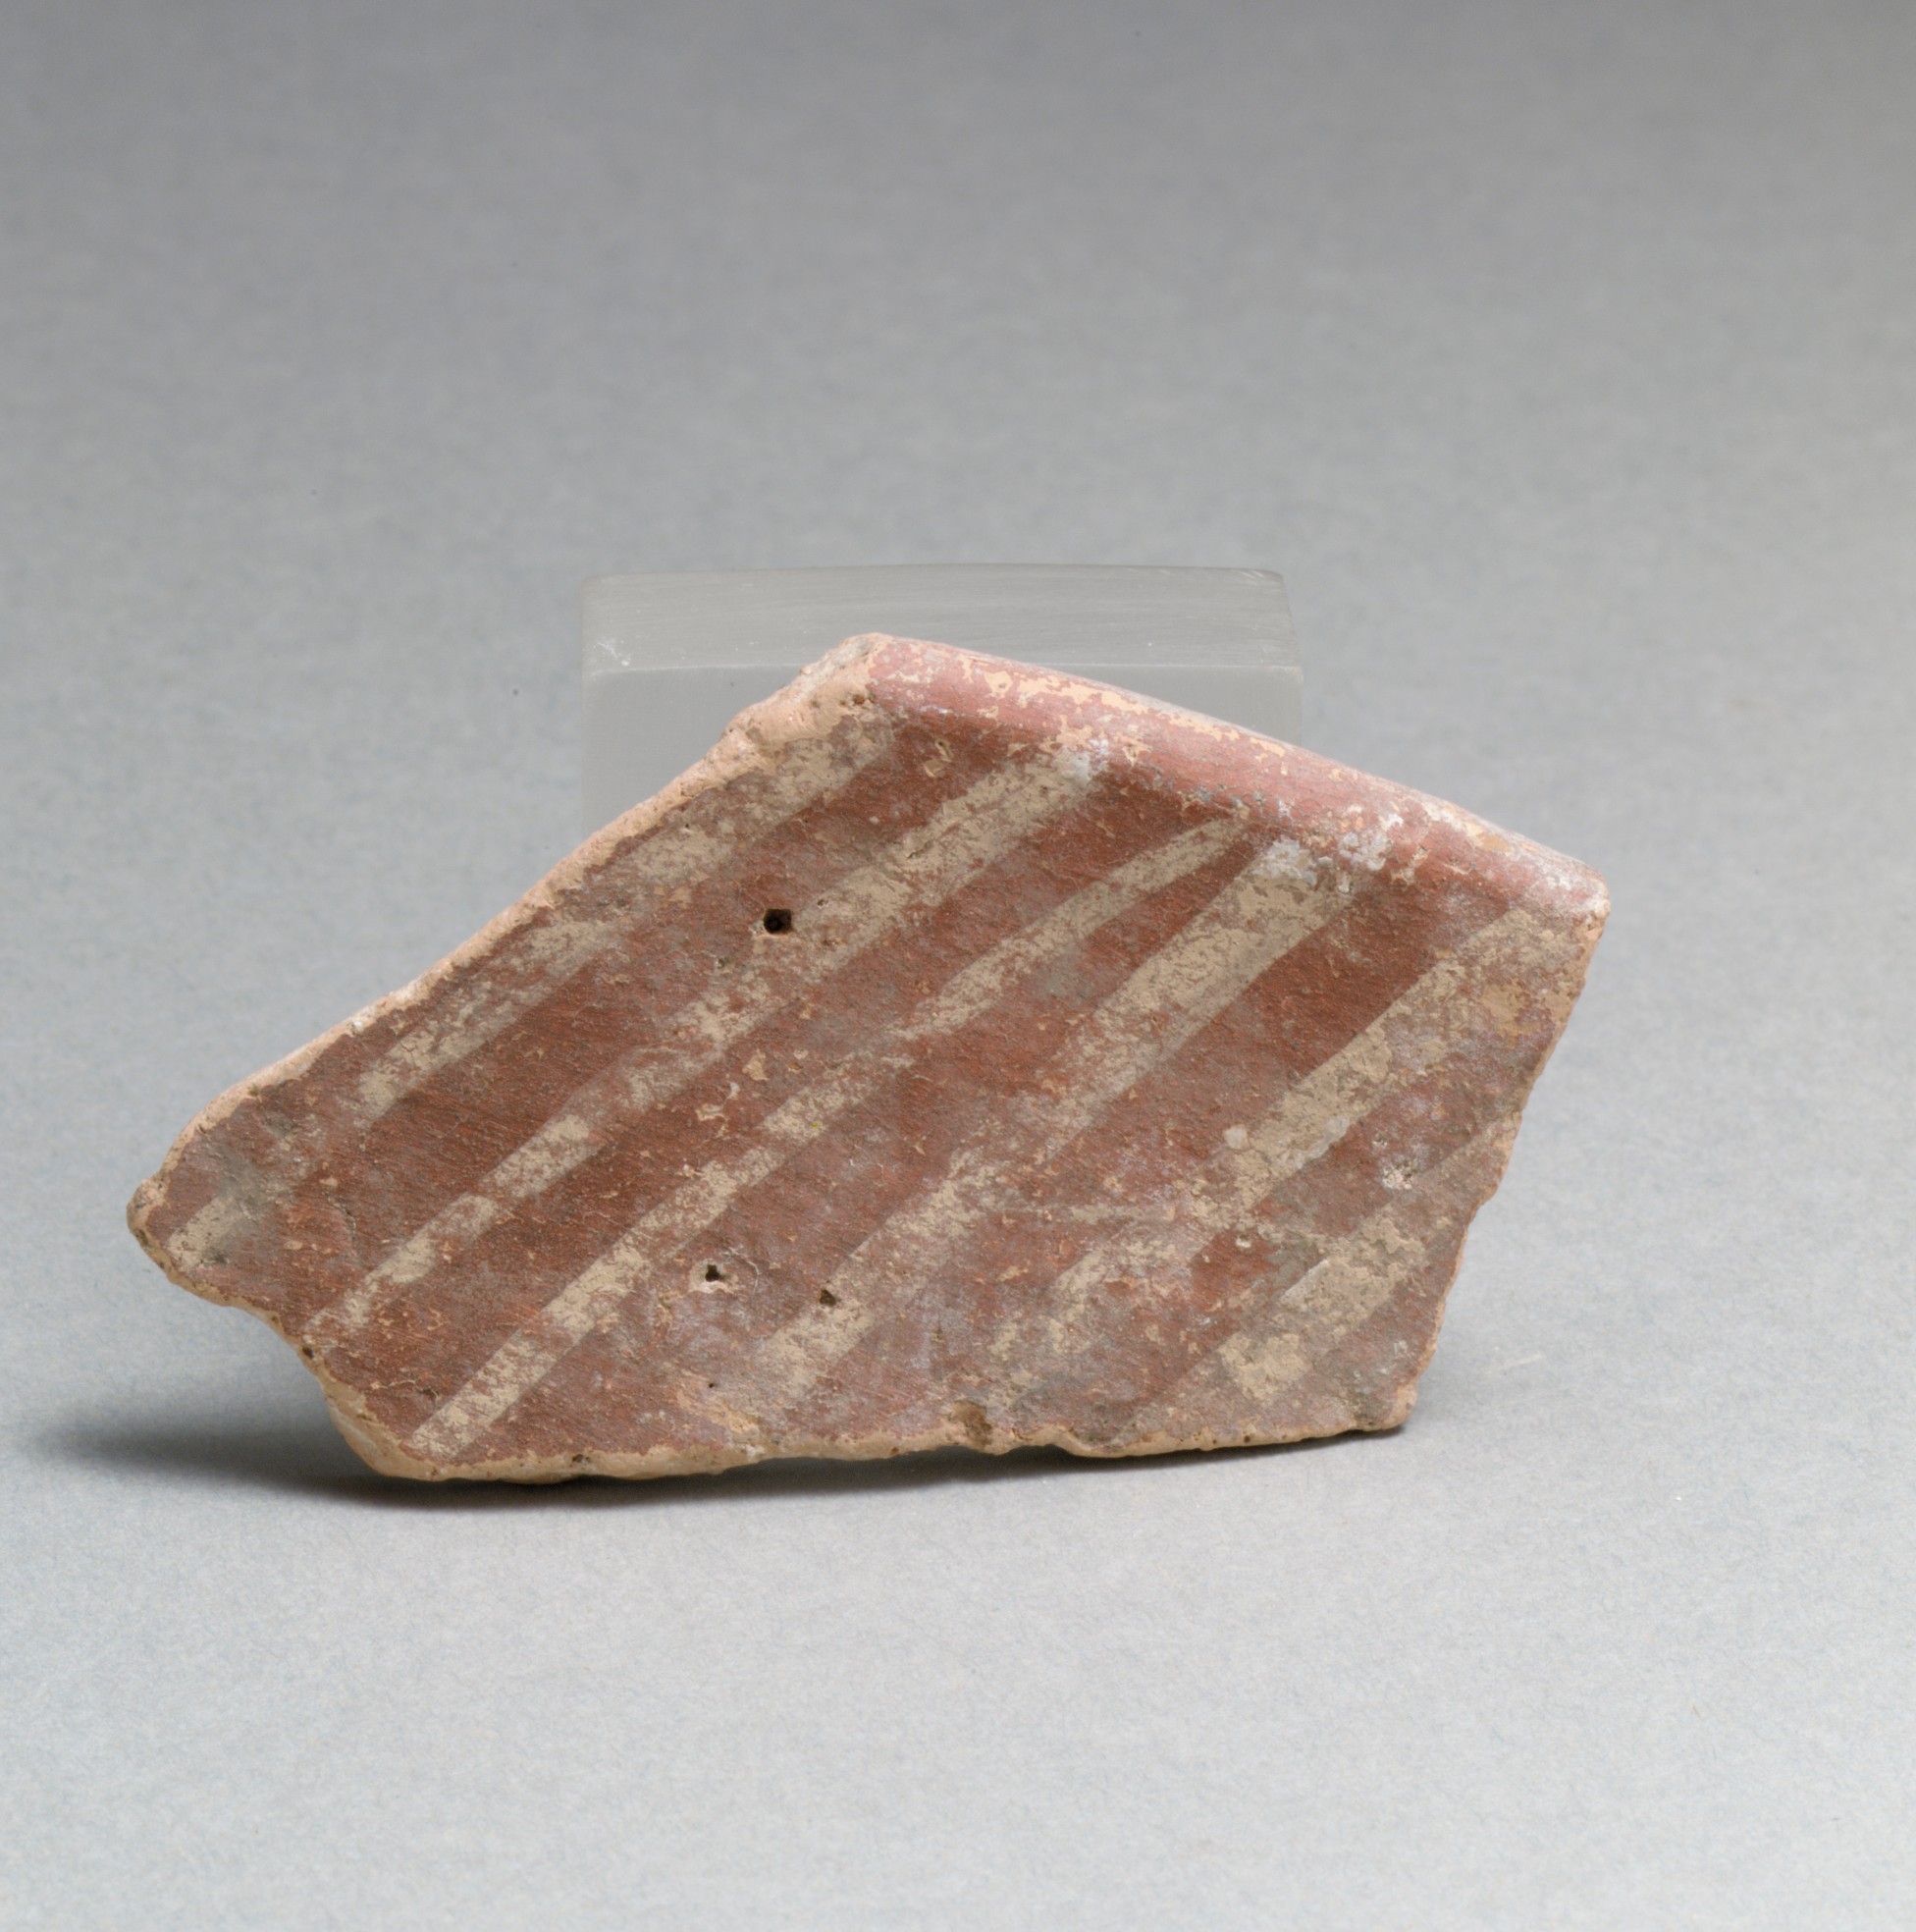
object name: vase fragment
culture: minoan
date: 2600-2000 BCE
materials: terracotta